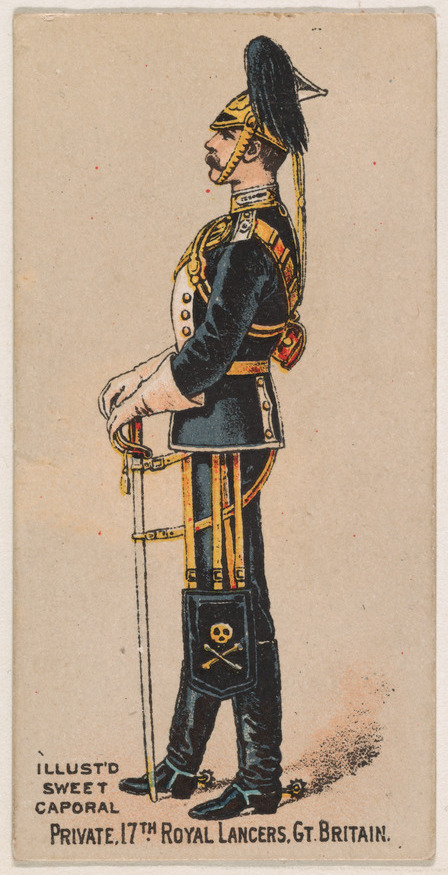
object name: print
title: Private, 17th Royal Lancers, Great Britain, from the Military Series (N224) issued by Kinney Tobacco Company to promote Sweet Caporal Cigarettes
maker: kinney brothers tobacco company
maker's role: publisher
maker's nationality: american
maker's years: 1869-2011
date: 1888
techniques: color lithograph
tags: military,swords,men,profiles